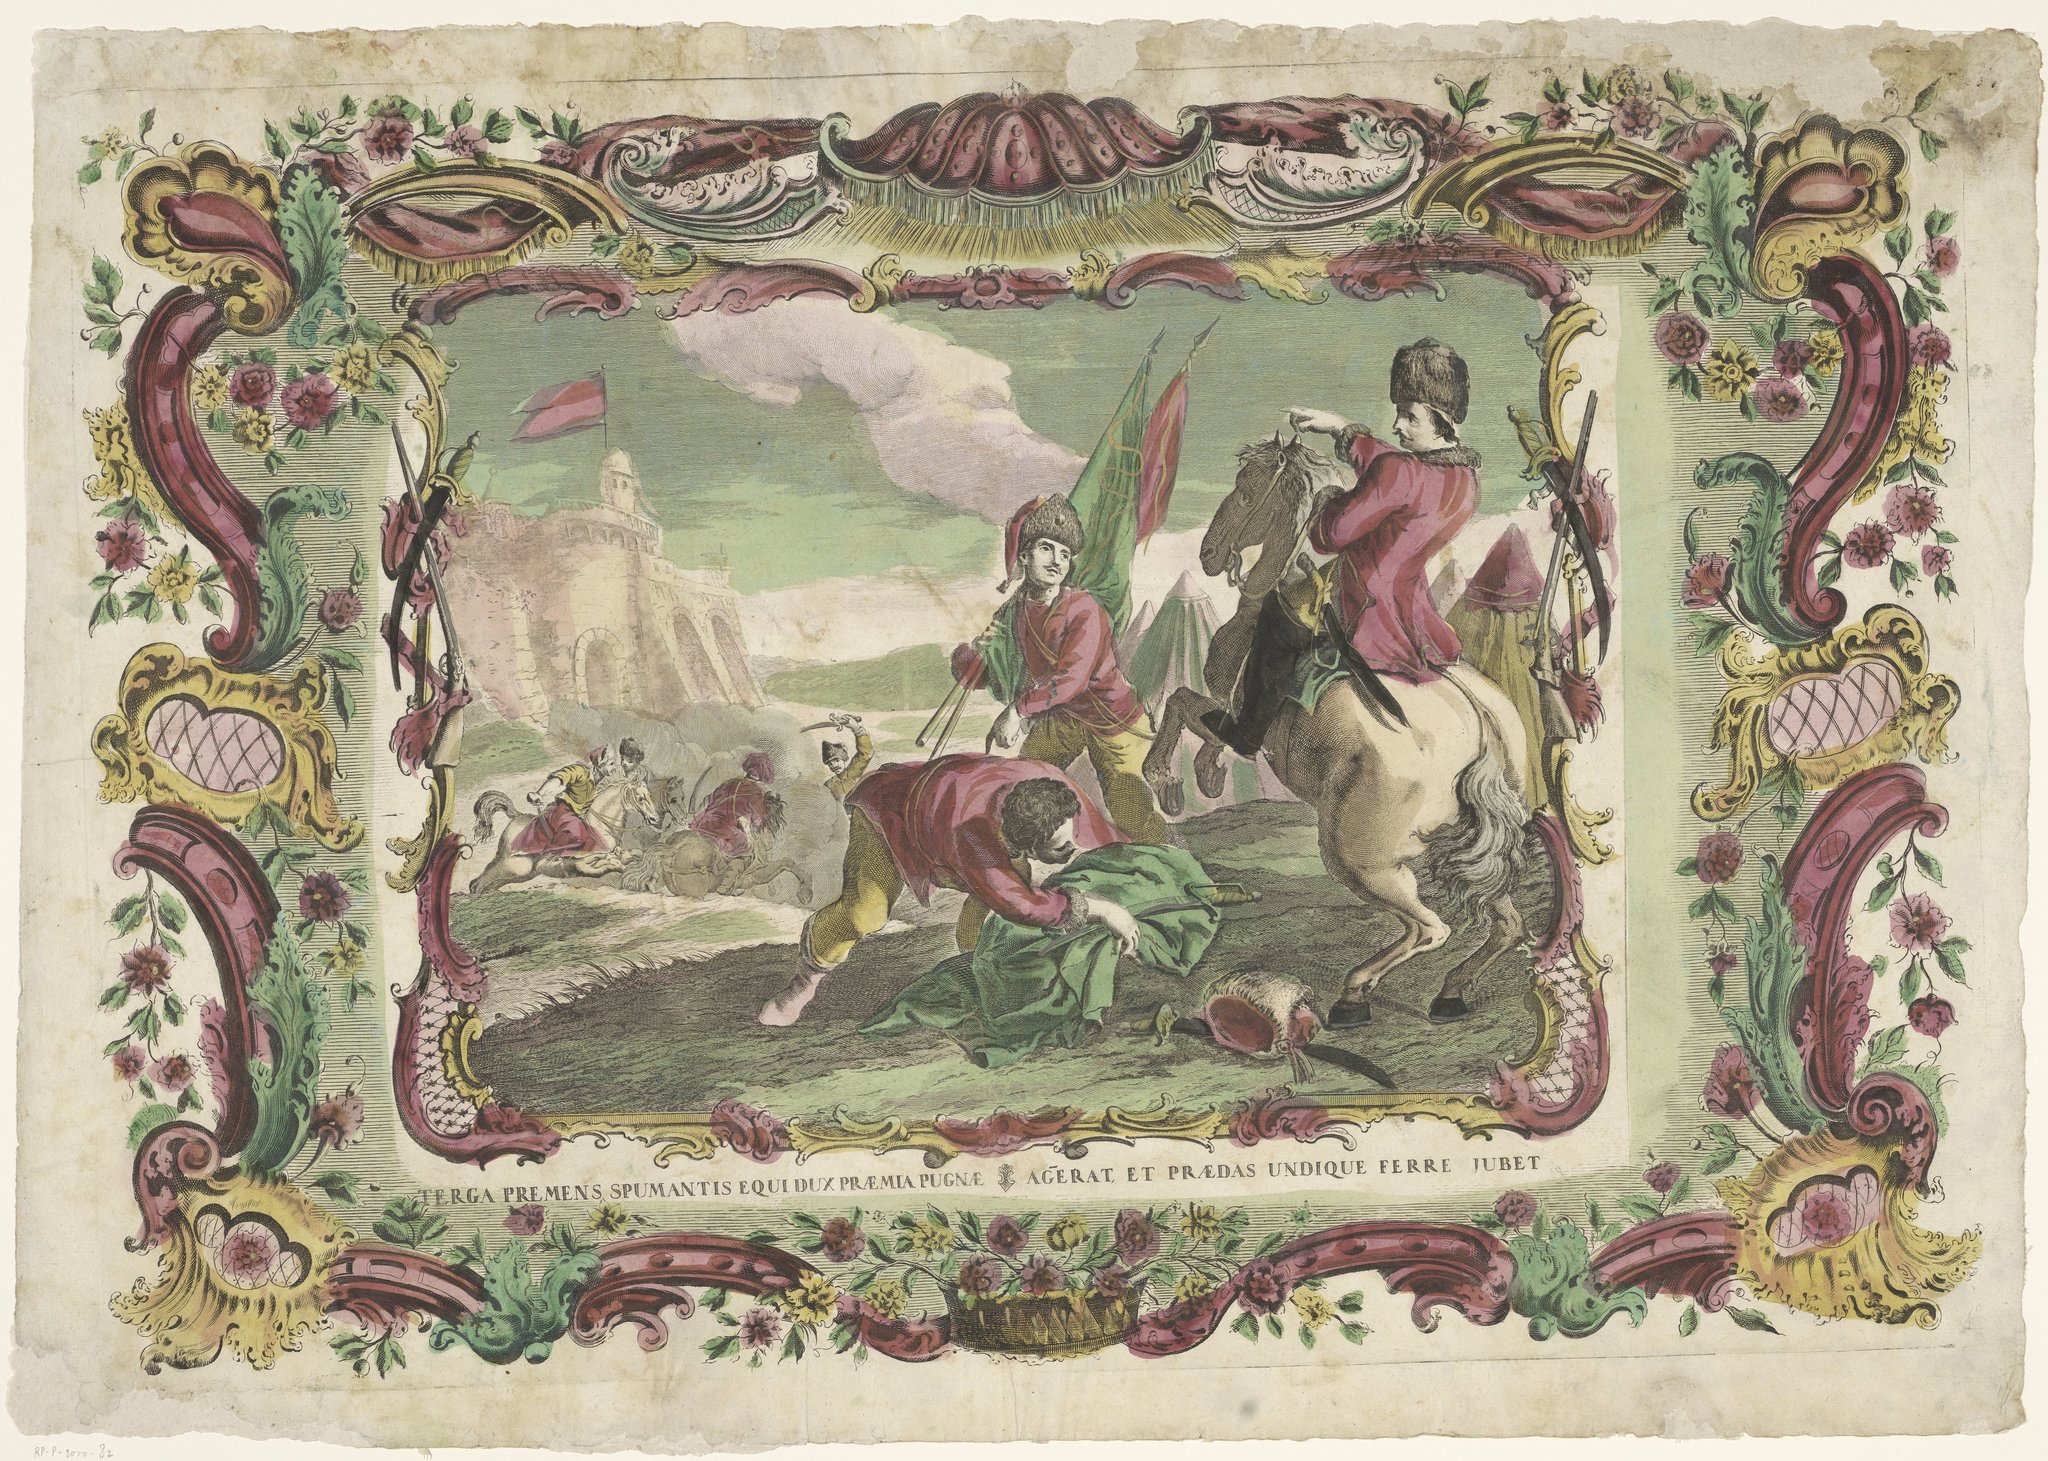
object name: print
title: Soldaten in een strijd voor een fort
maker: giovanni volpato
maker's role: ceramicist, print maker, printer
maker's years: 1735-1803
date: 1700-1799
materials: paper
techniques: colour, engraving, etching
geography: bassano del grappa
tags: ornaments ~ art, warfare; military affairs (+ cavalry, horsemen), the soldier; the soldier's life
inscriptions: collector's mark: Lugt 2760, collector's mark: Lugt 2228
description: Rechtsvoor een officier te paard en twee soldaten. Een van hen raapt een uitrusting op. Linksachter een fort waarvoor gevochten wordt. Titel onder voorstelling. De scène is gevat in een ornamentrand.